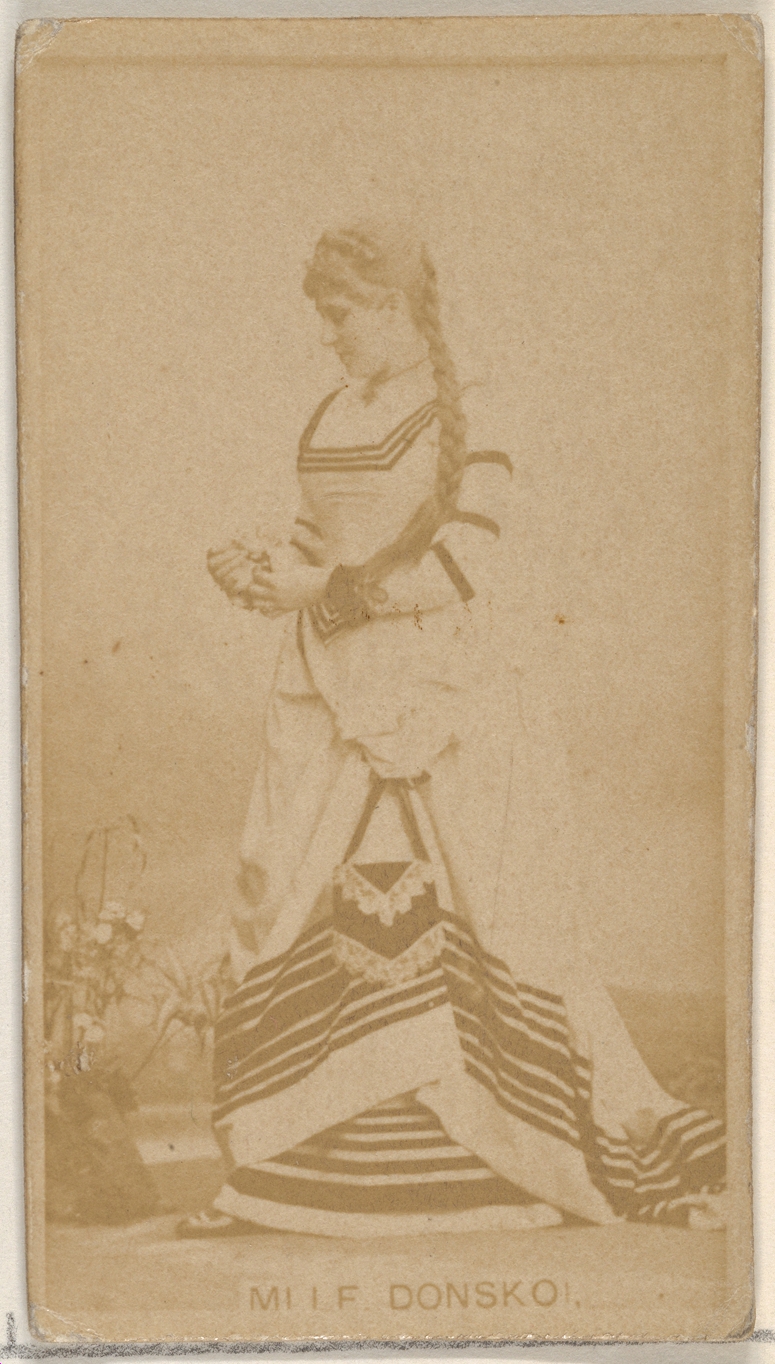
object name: photograph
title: Mlle. Donsko, from the Actors and Actresses series (N45, Type 8) for Virginia Brights Cigarettes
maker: allen & ginter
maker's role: publisher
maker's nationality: american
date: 1888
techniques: albumen silver print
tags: portraits,women,actresses